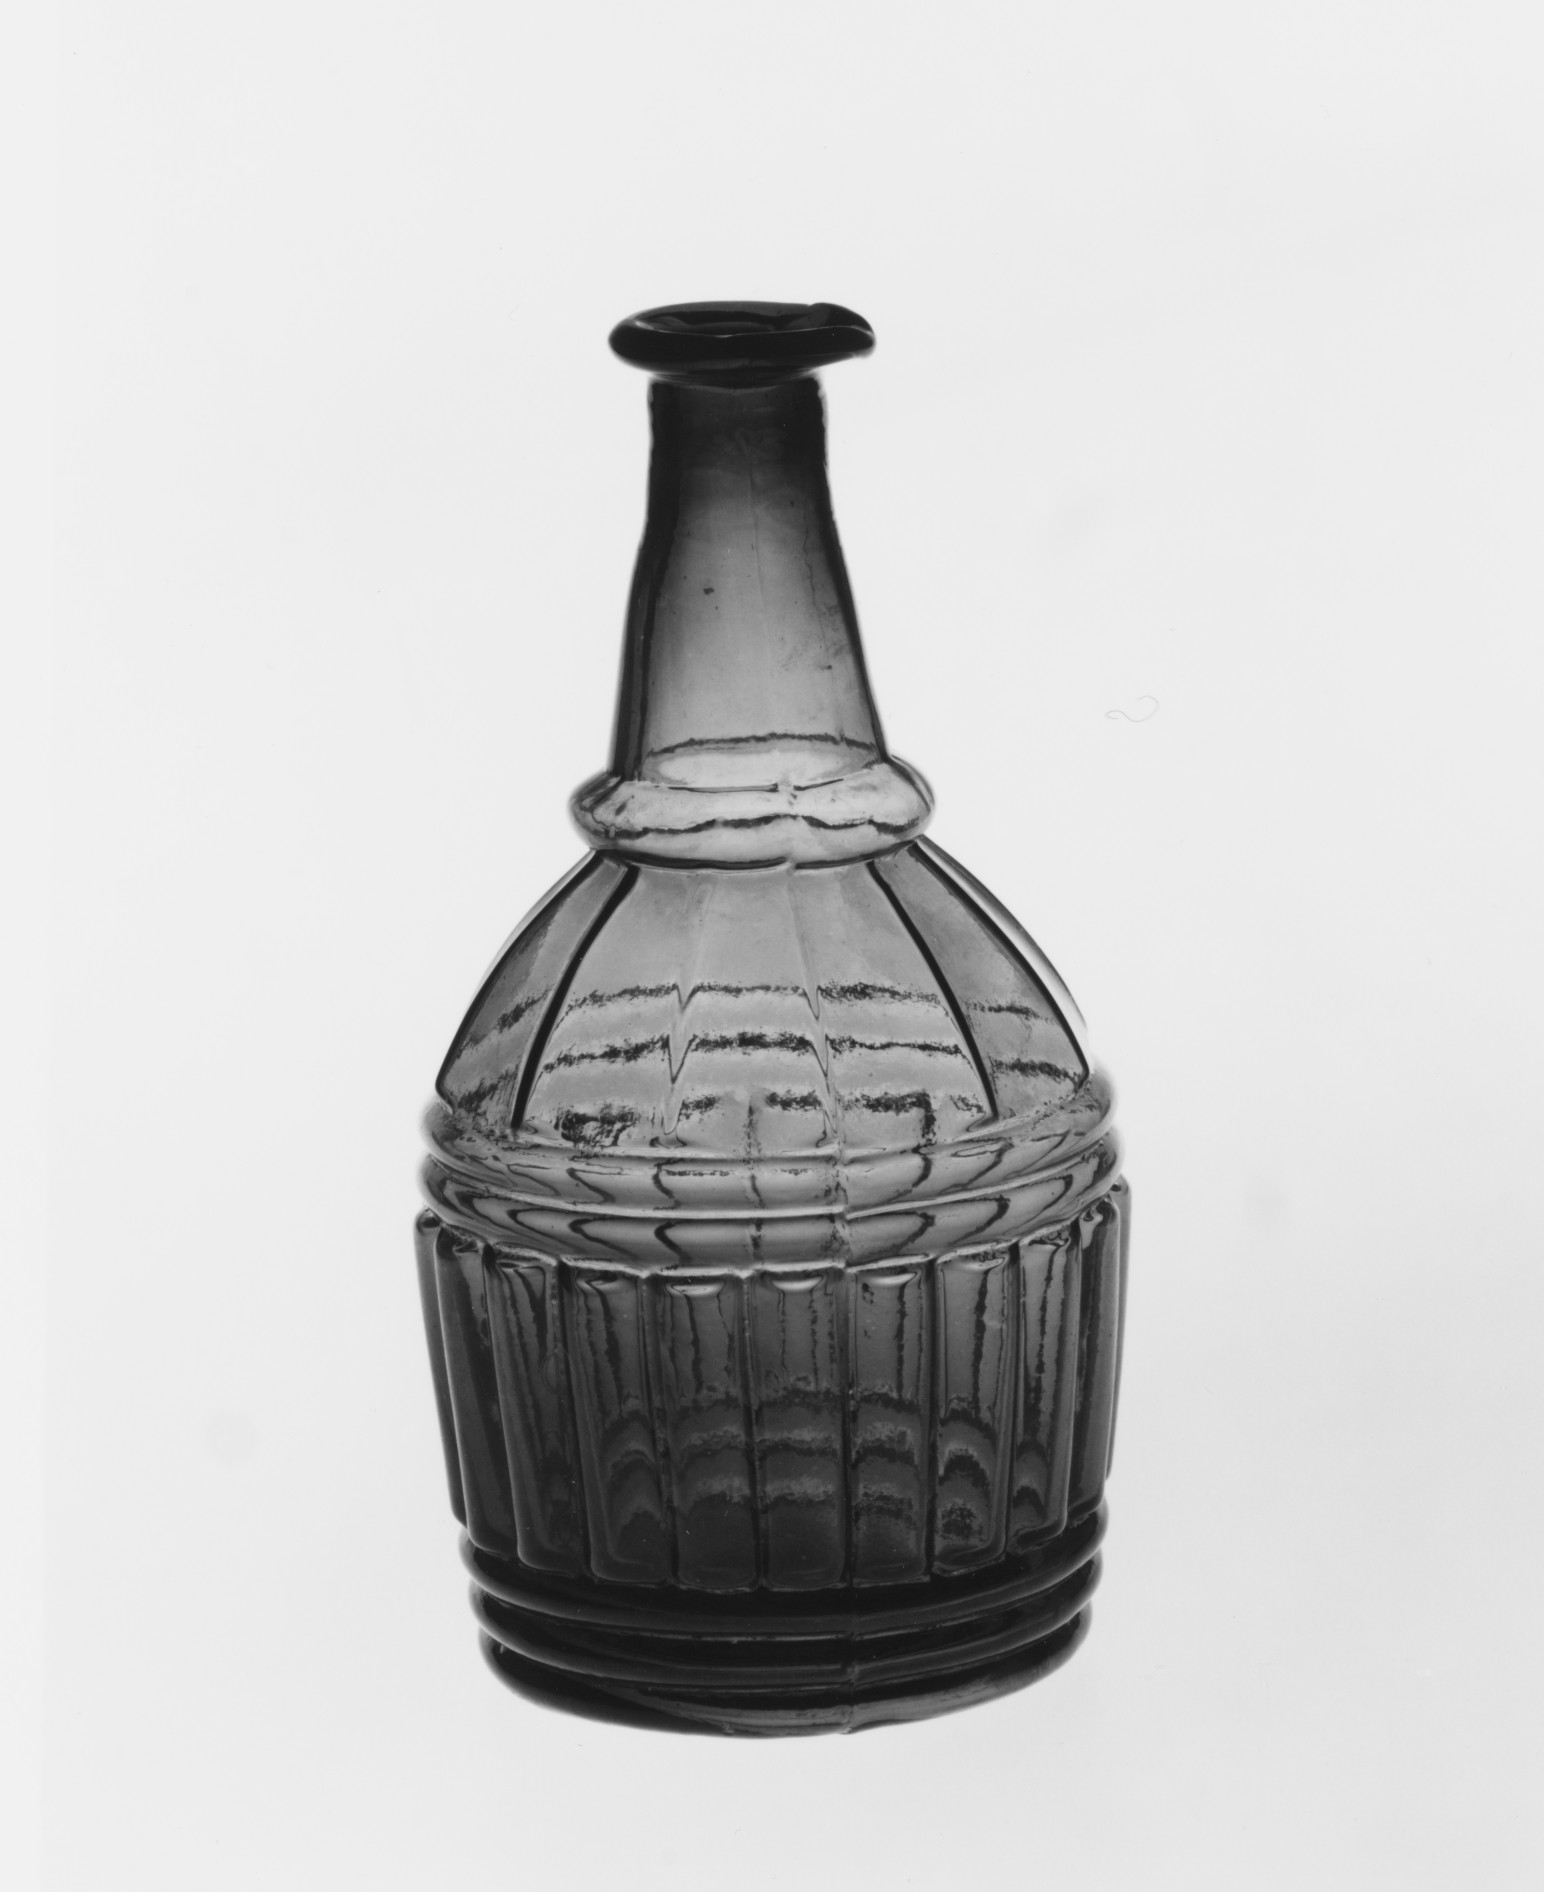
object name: decanter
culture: american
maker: boston & sandwich glass company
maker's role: maker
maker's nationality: american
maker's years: 1825-1888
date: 1825-1892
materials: glass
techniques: glassblowing, molding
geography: united states